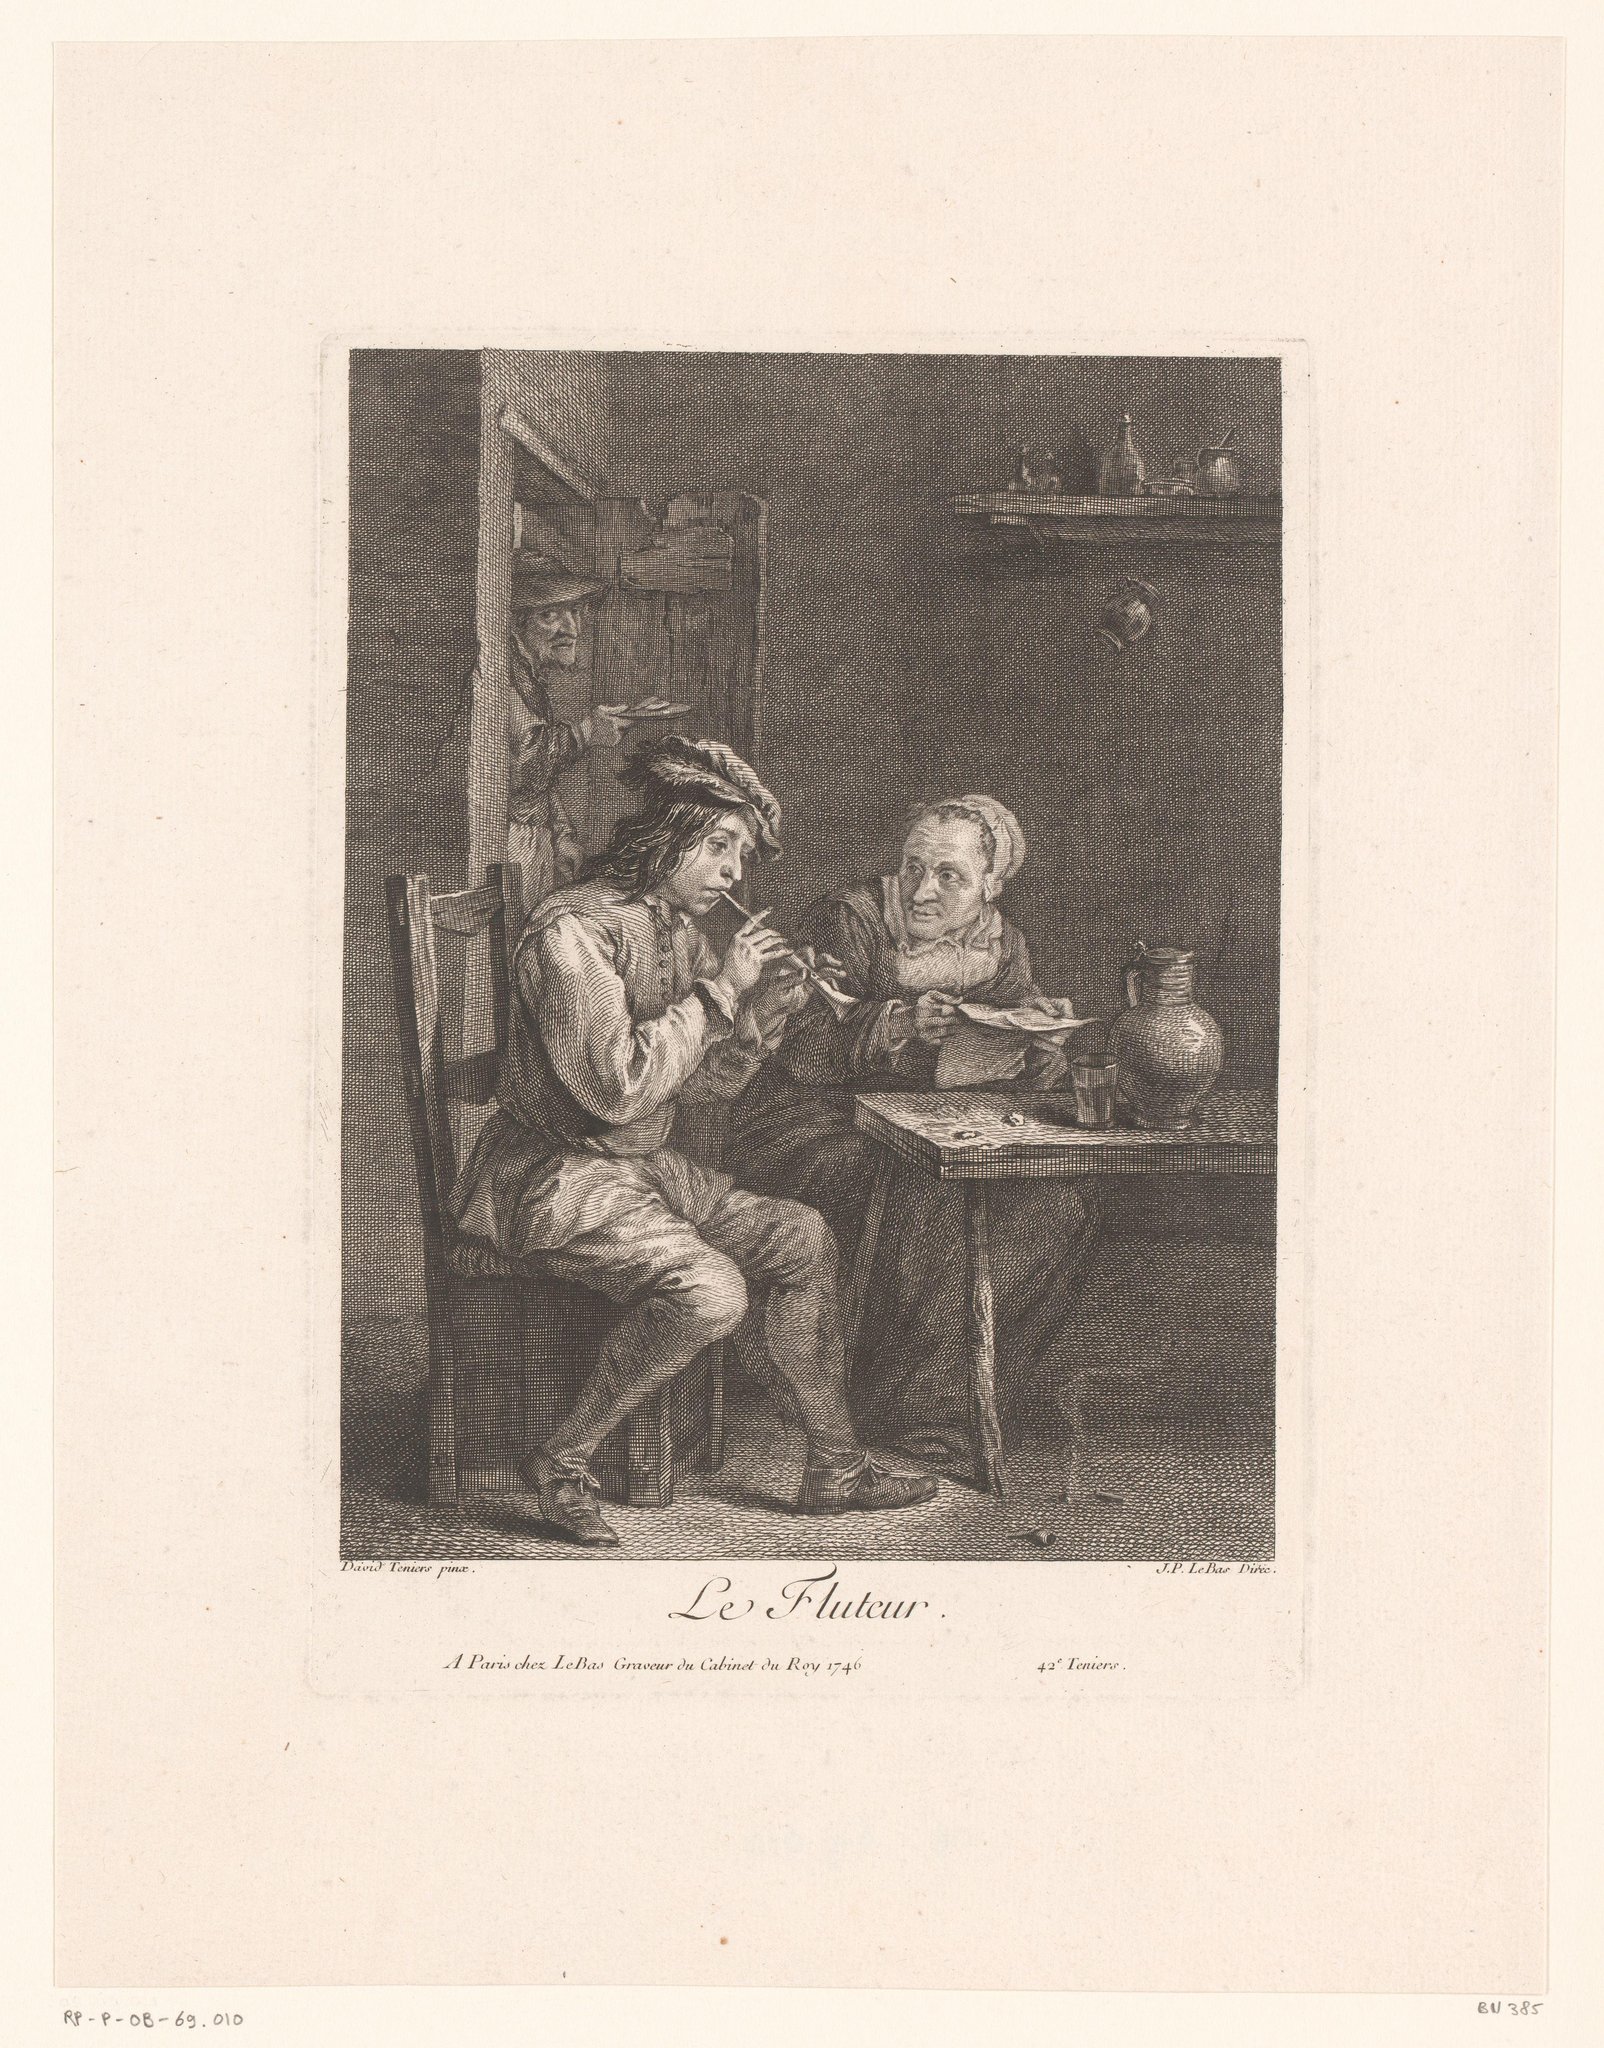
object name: print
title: Interieur met een fluitspeler en een oude vrouw aan een tafel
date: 1746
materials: paper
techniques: engraving, etching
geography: paris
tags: making music; musician with instrument, one person playing wind instrument, flute, aulos, tibia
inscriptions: date